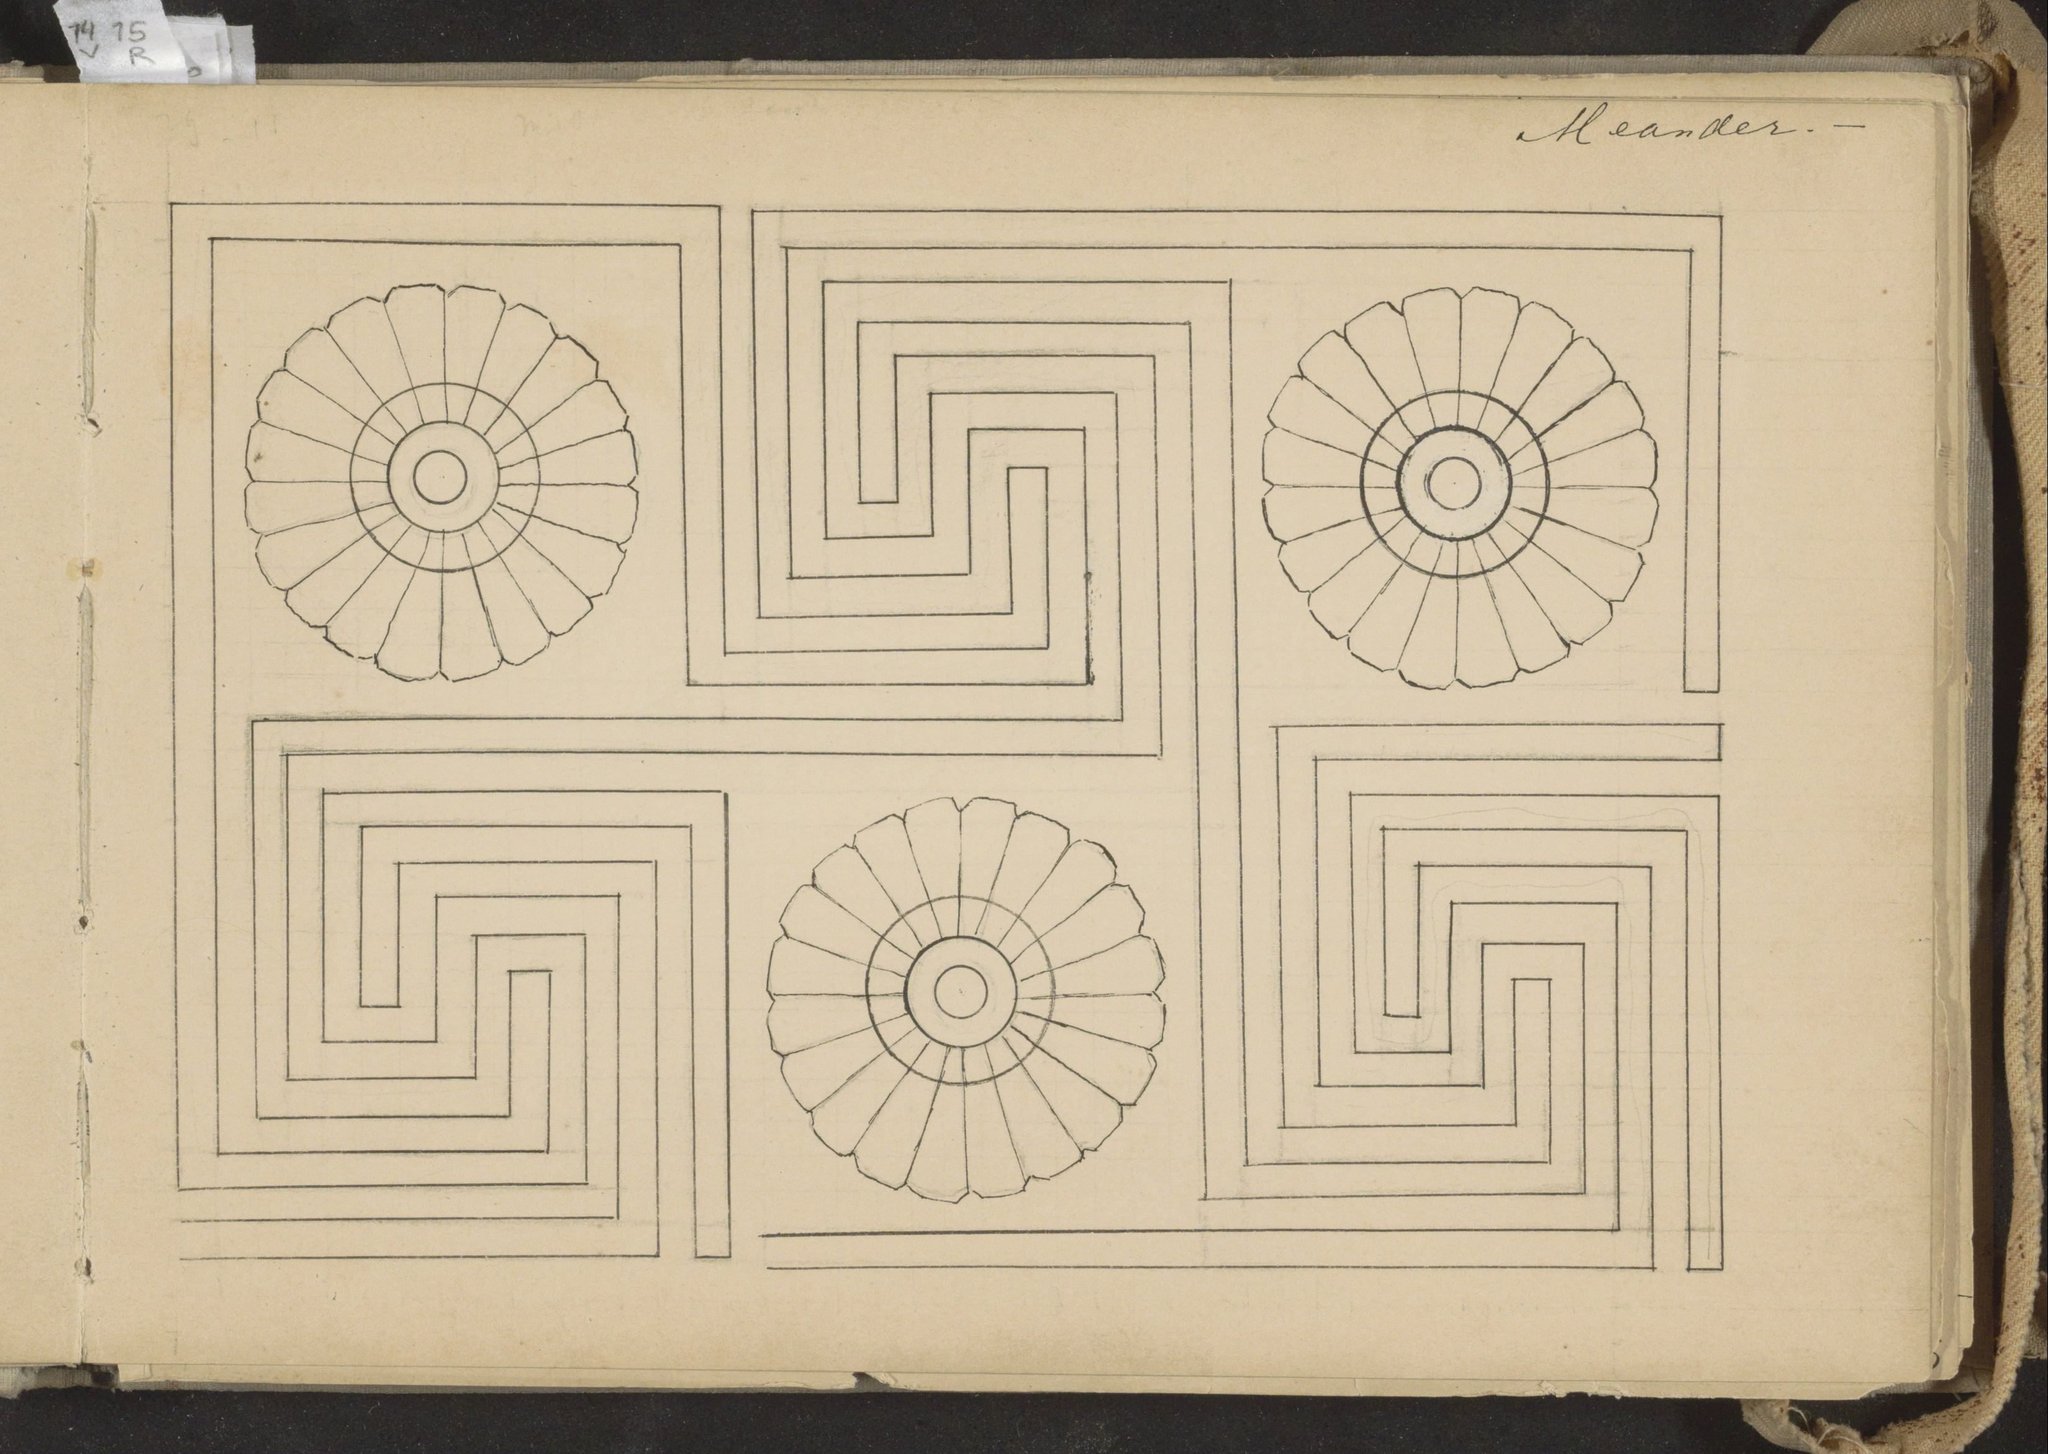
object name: sketchbook leaf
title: Motief met meander en gestileerde bloemen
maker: johanna van de kamer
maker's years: 1873-1922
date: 1890-1922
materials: ink, paper, pencil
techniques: pen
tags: flowers ~ ornament - aa - stylized, ornament ~ meander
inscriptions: annotation: ‘Meander.-’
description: Blad 11 recto uit een schetsboek met 43 bladen.